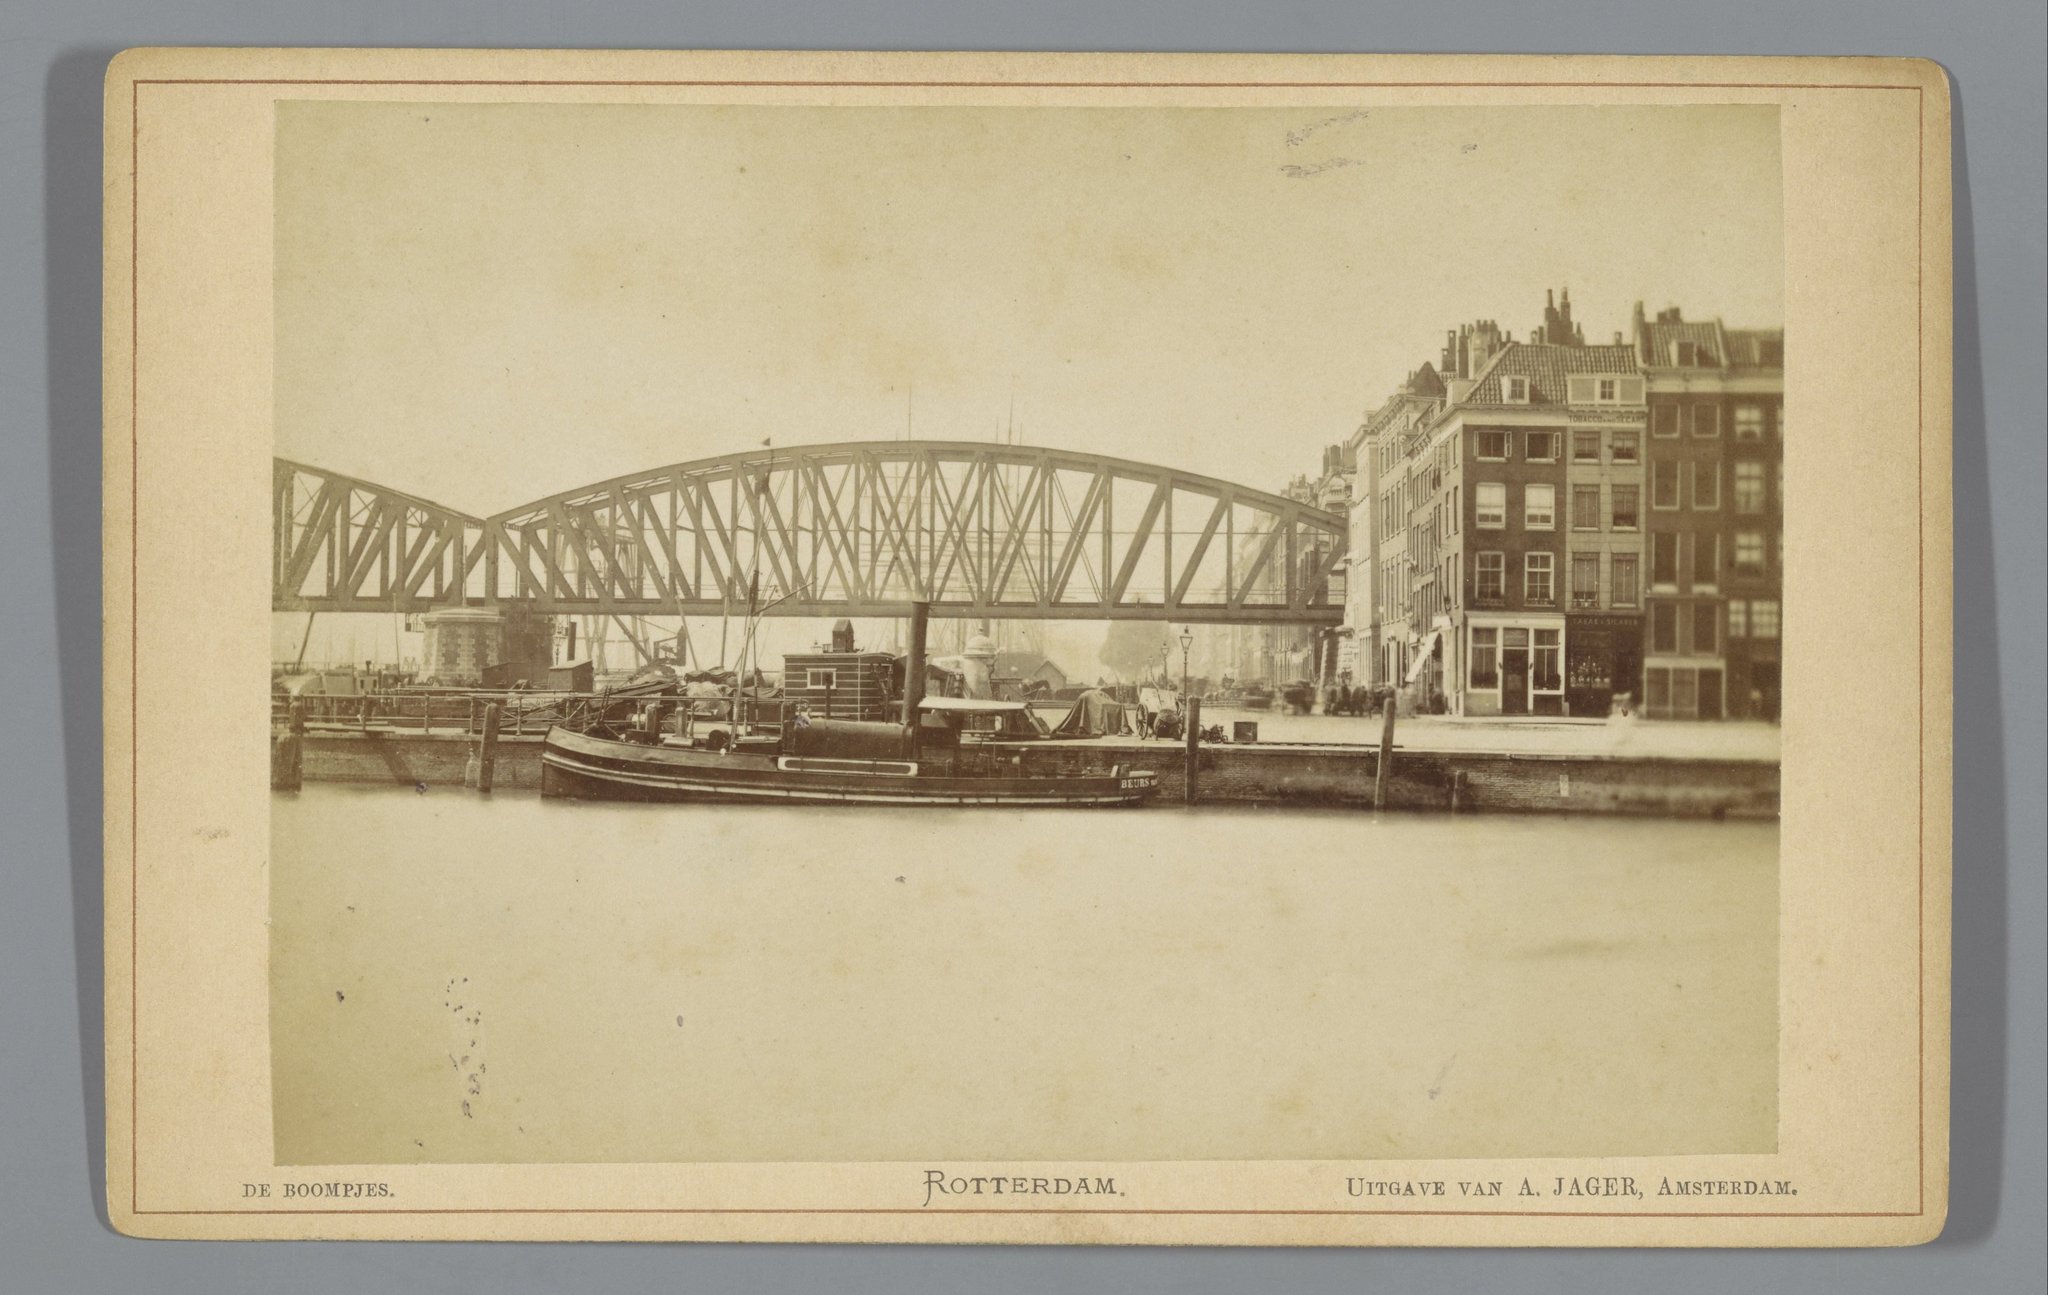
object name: cabinet photograph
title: De Boompjes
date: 1877-1890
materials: cardboard, photographic support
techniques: albumen print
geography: amsterdam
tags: canals, waters (in city), bridge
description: Gezicht op de Boompjes in Rotterdam met de spoorbrug over de Nieuwe Maas.